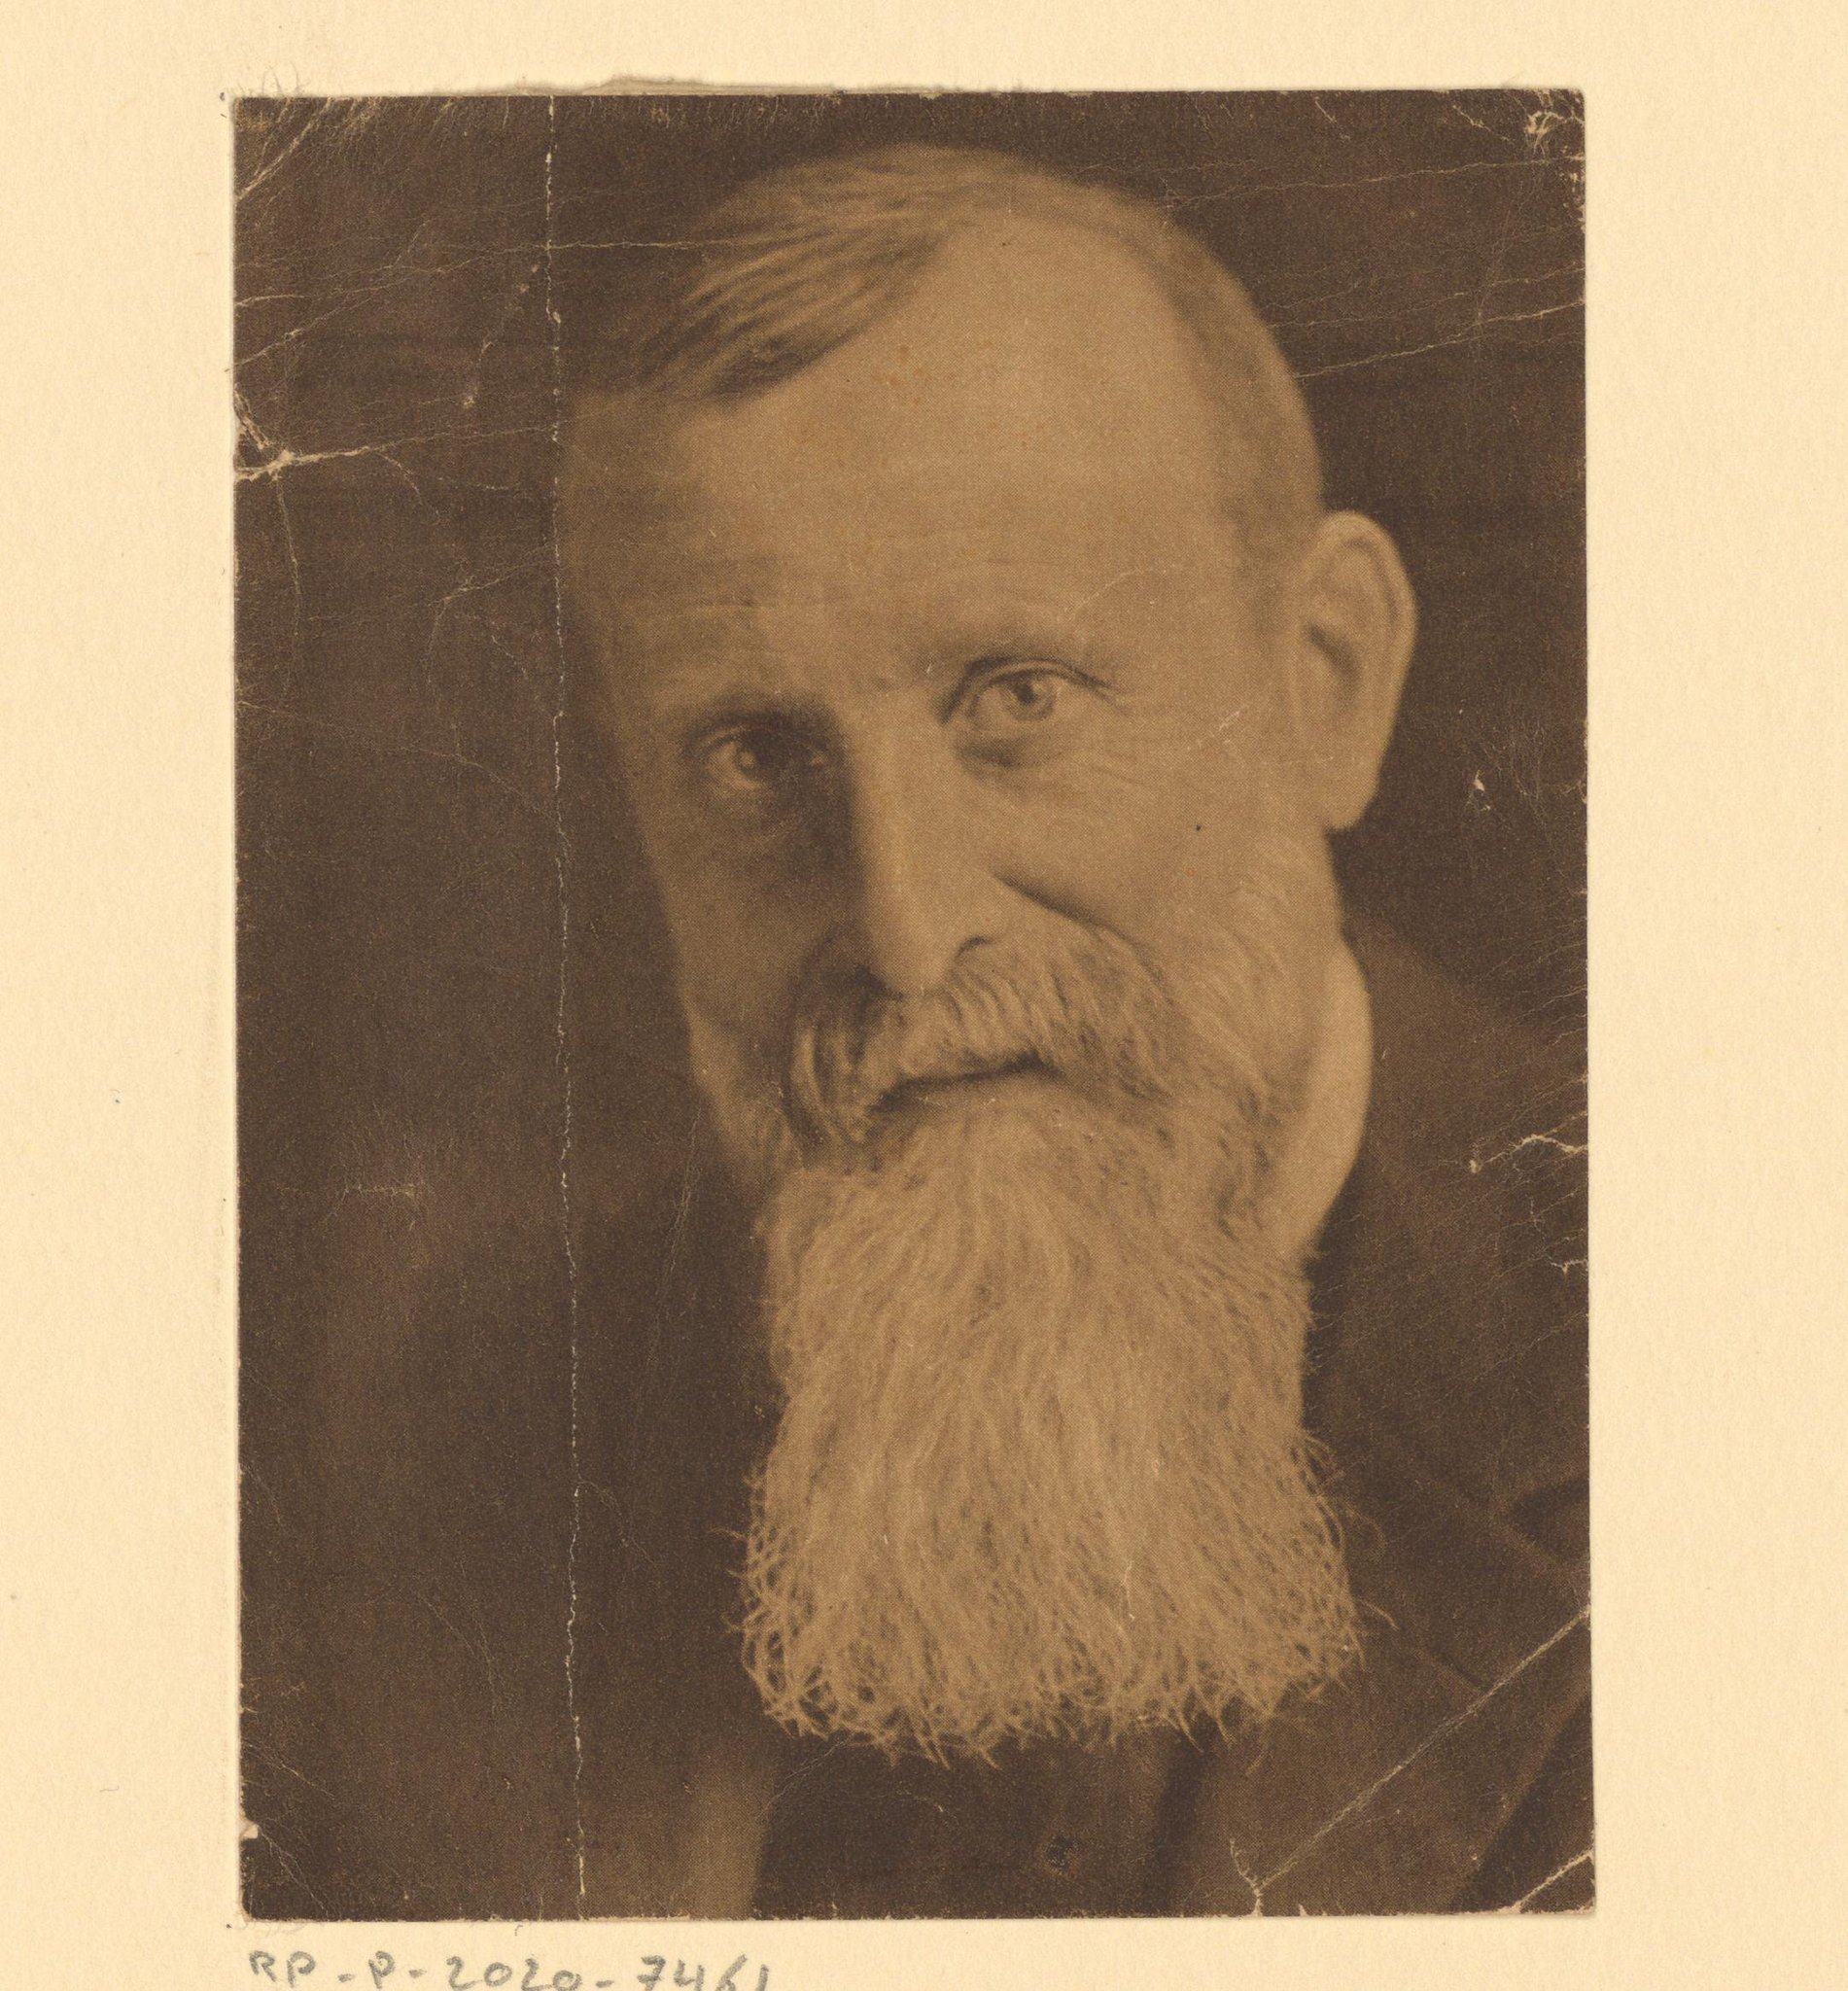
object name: photomechanical print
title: Portret van George Frans Haspels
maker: Anonymous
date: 1900-1935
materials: paper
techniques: rotogravure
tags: nijmegen, arnhem, historical persons, portrait of a writer